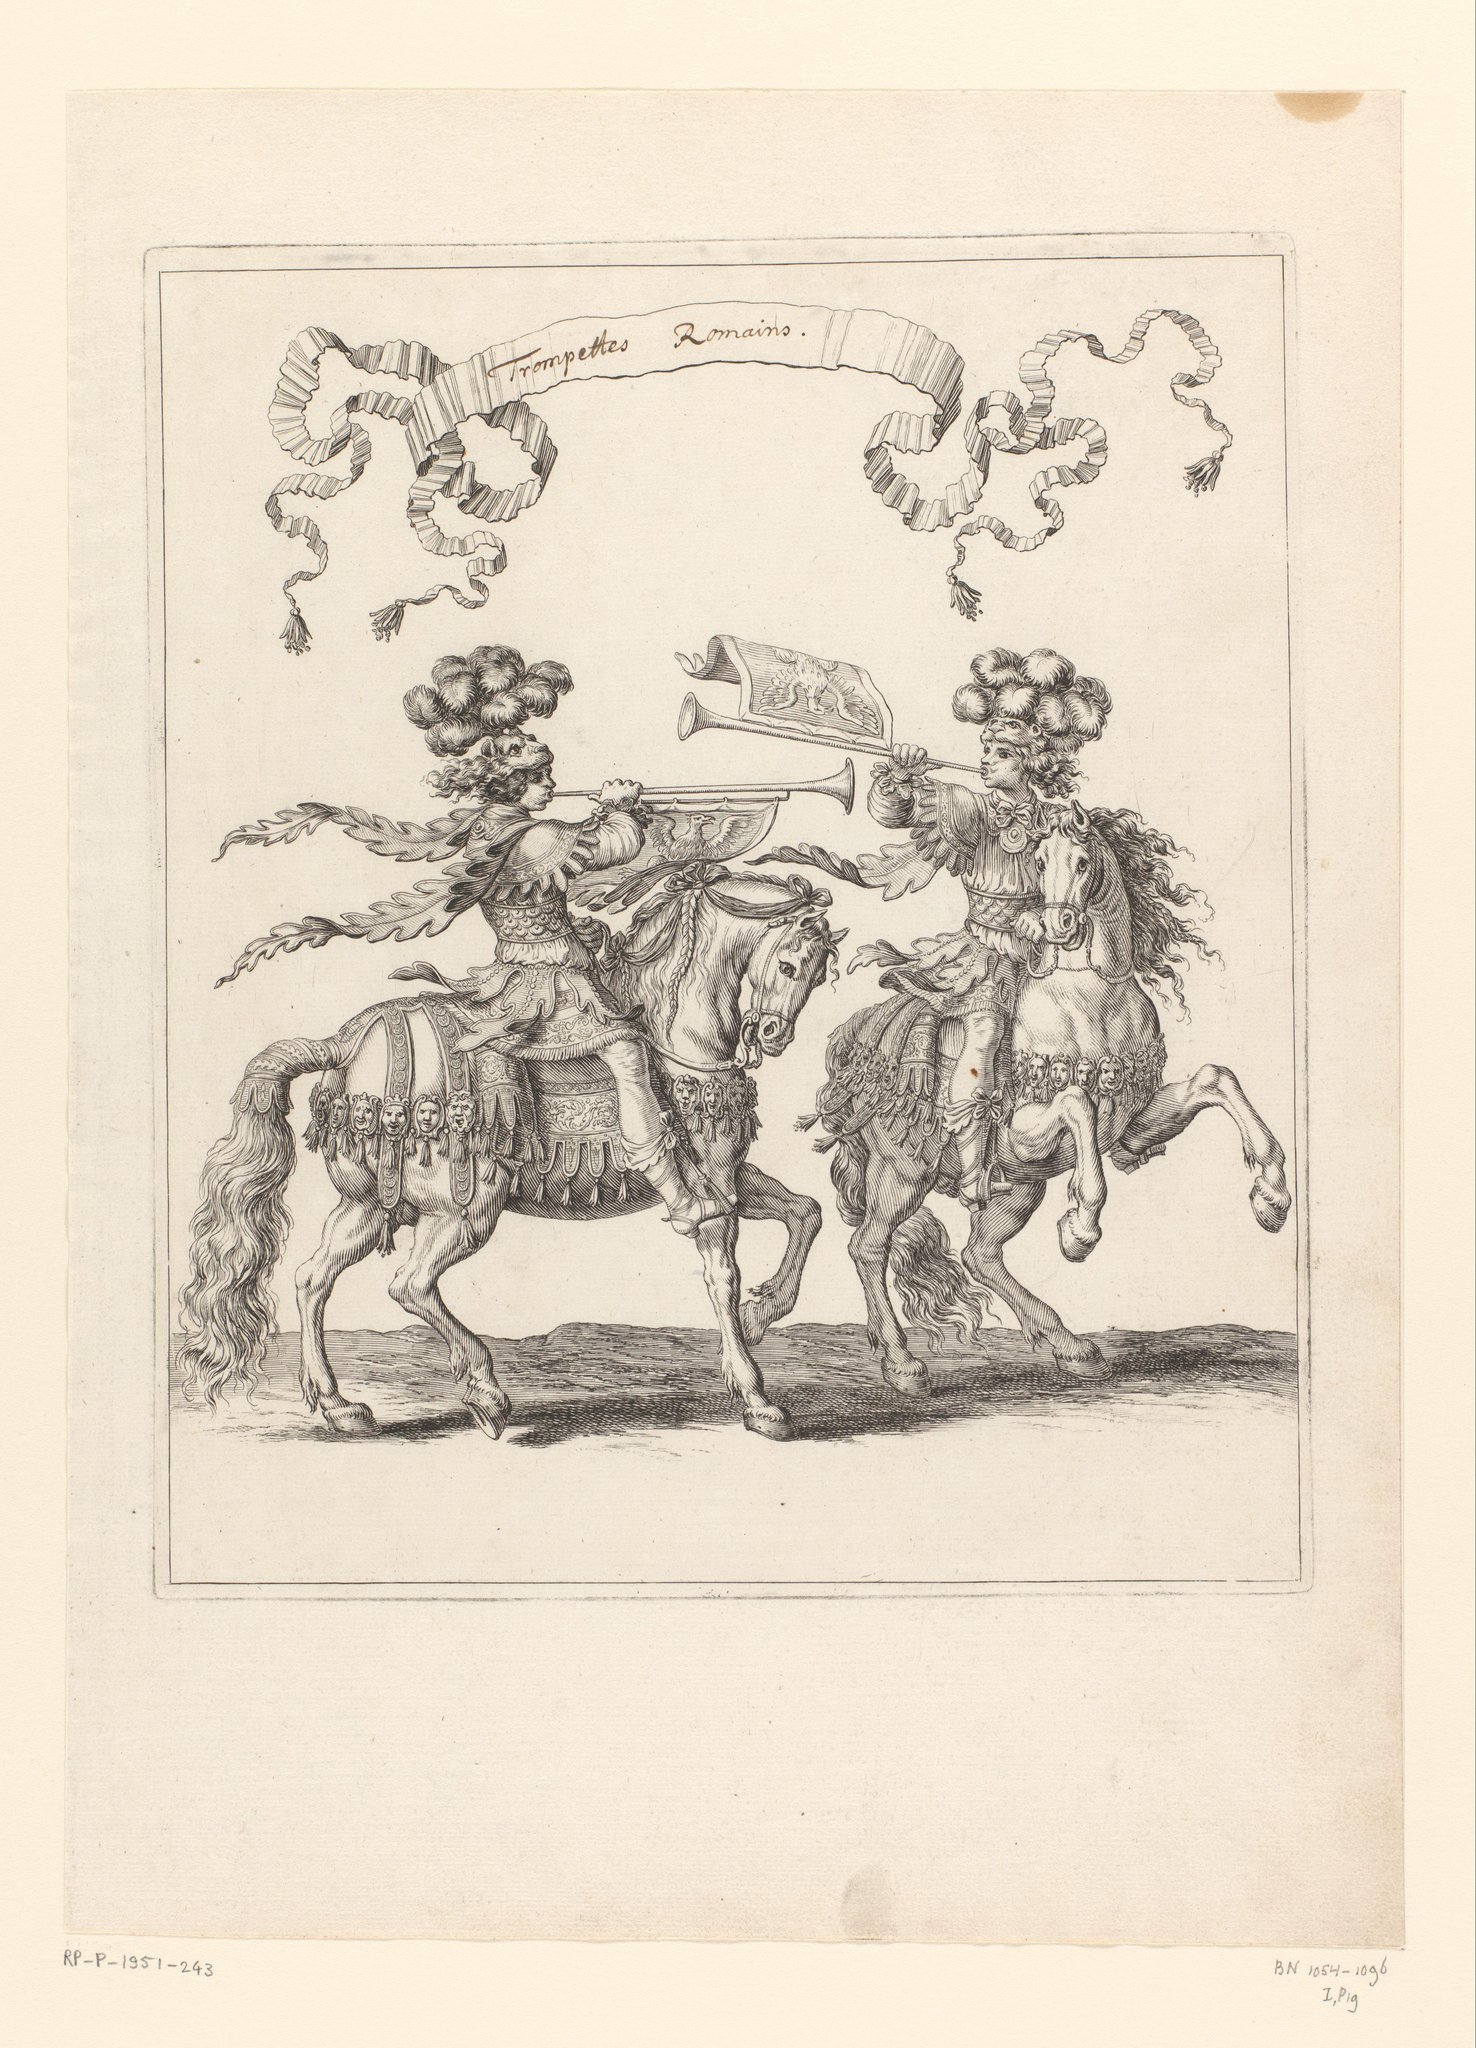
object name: print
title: Trompettisten te paard in Romeins kostuum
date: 1670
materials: paper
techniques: etching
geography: paris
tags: horn, trumpet, cornet, trombone, tuba, tournament, horse, festivities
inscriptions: collector's mark: Lugt 2228, inscription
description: Prent uit: Perrault, Charles. Courses de testes et de bague faites par le Roy et par les princes et seigneurs de sa cour en l'année M.DC.LXII. Parijs: Imprimerie Royale, 1670. De prenten illustreren de door Lodewijk XIV georganiseerde festiviteiten in juni 1662 te Tuileries, zoals steekspelen met figuren in verschillende kostuums.